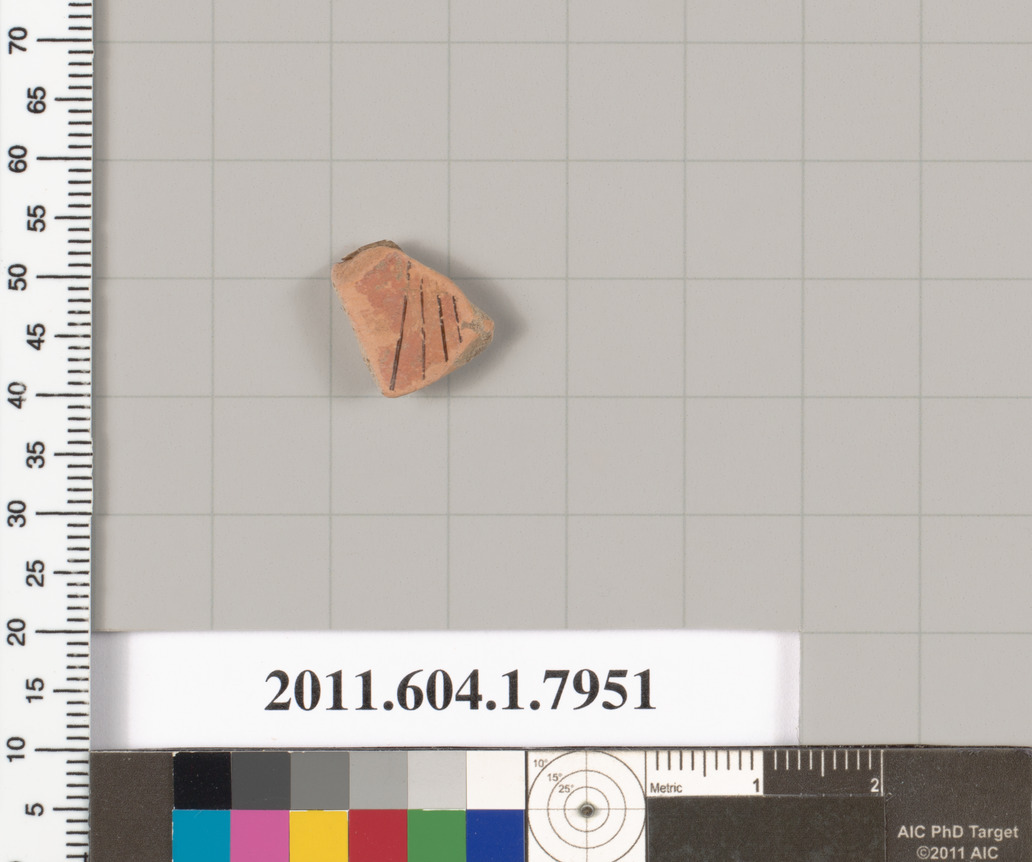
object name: kylix fragment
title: Terracotta fragment of a kylix (drinking cup)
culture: greek, attic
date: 460-450 BCE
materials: terracotta